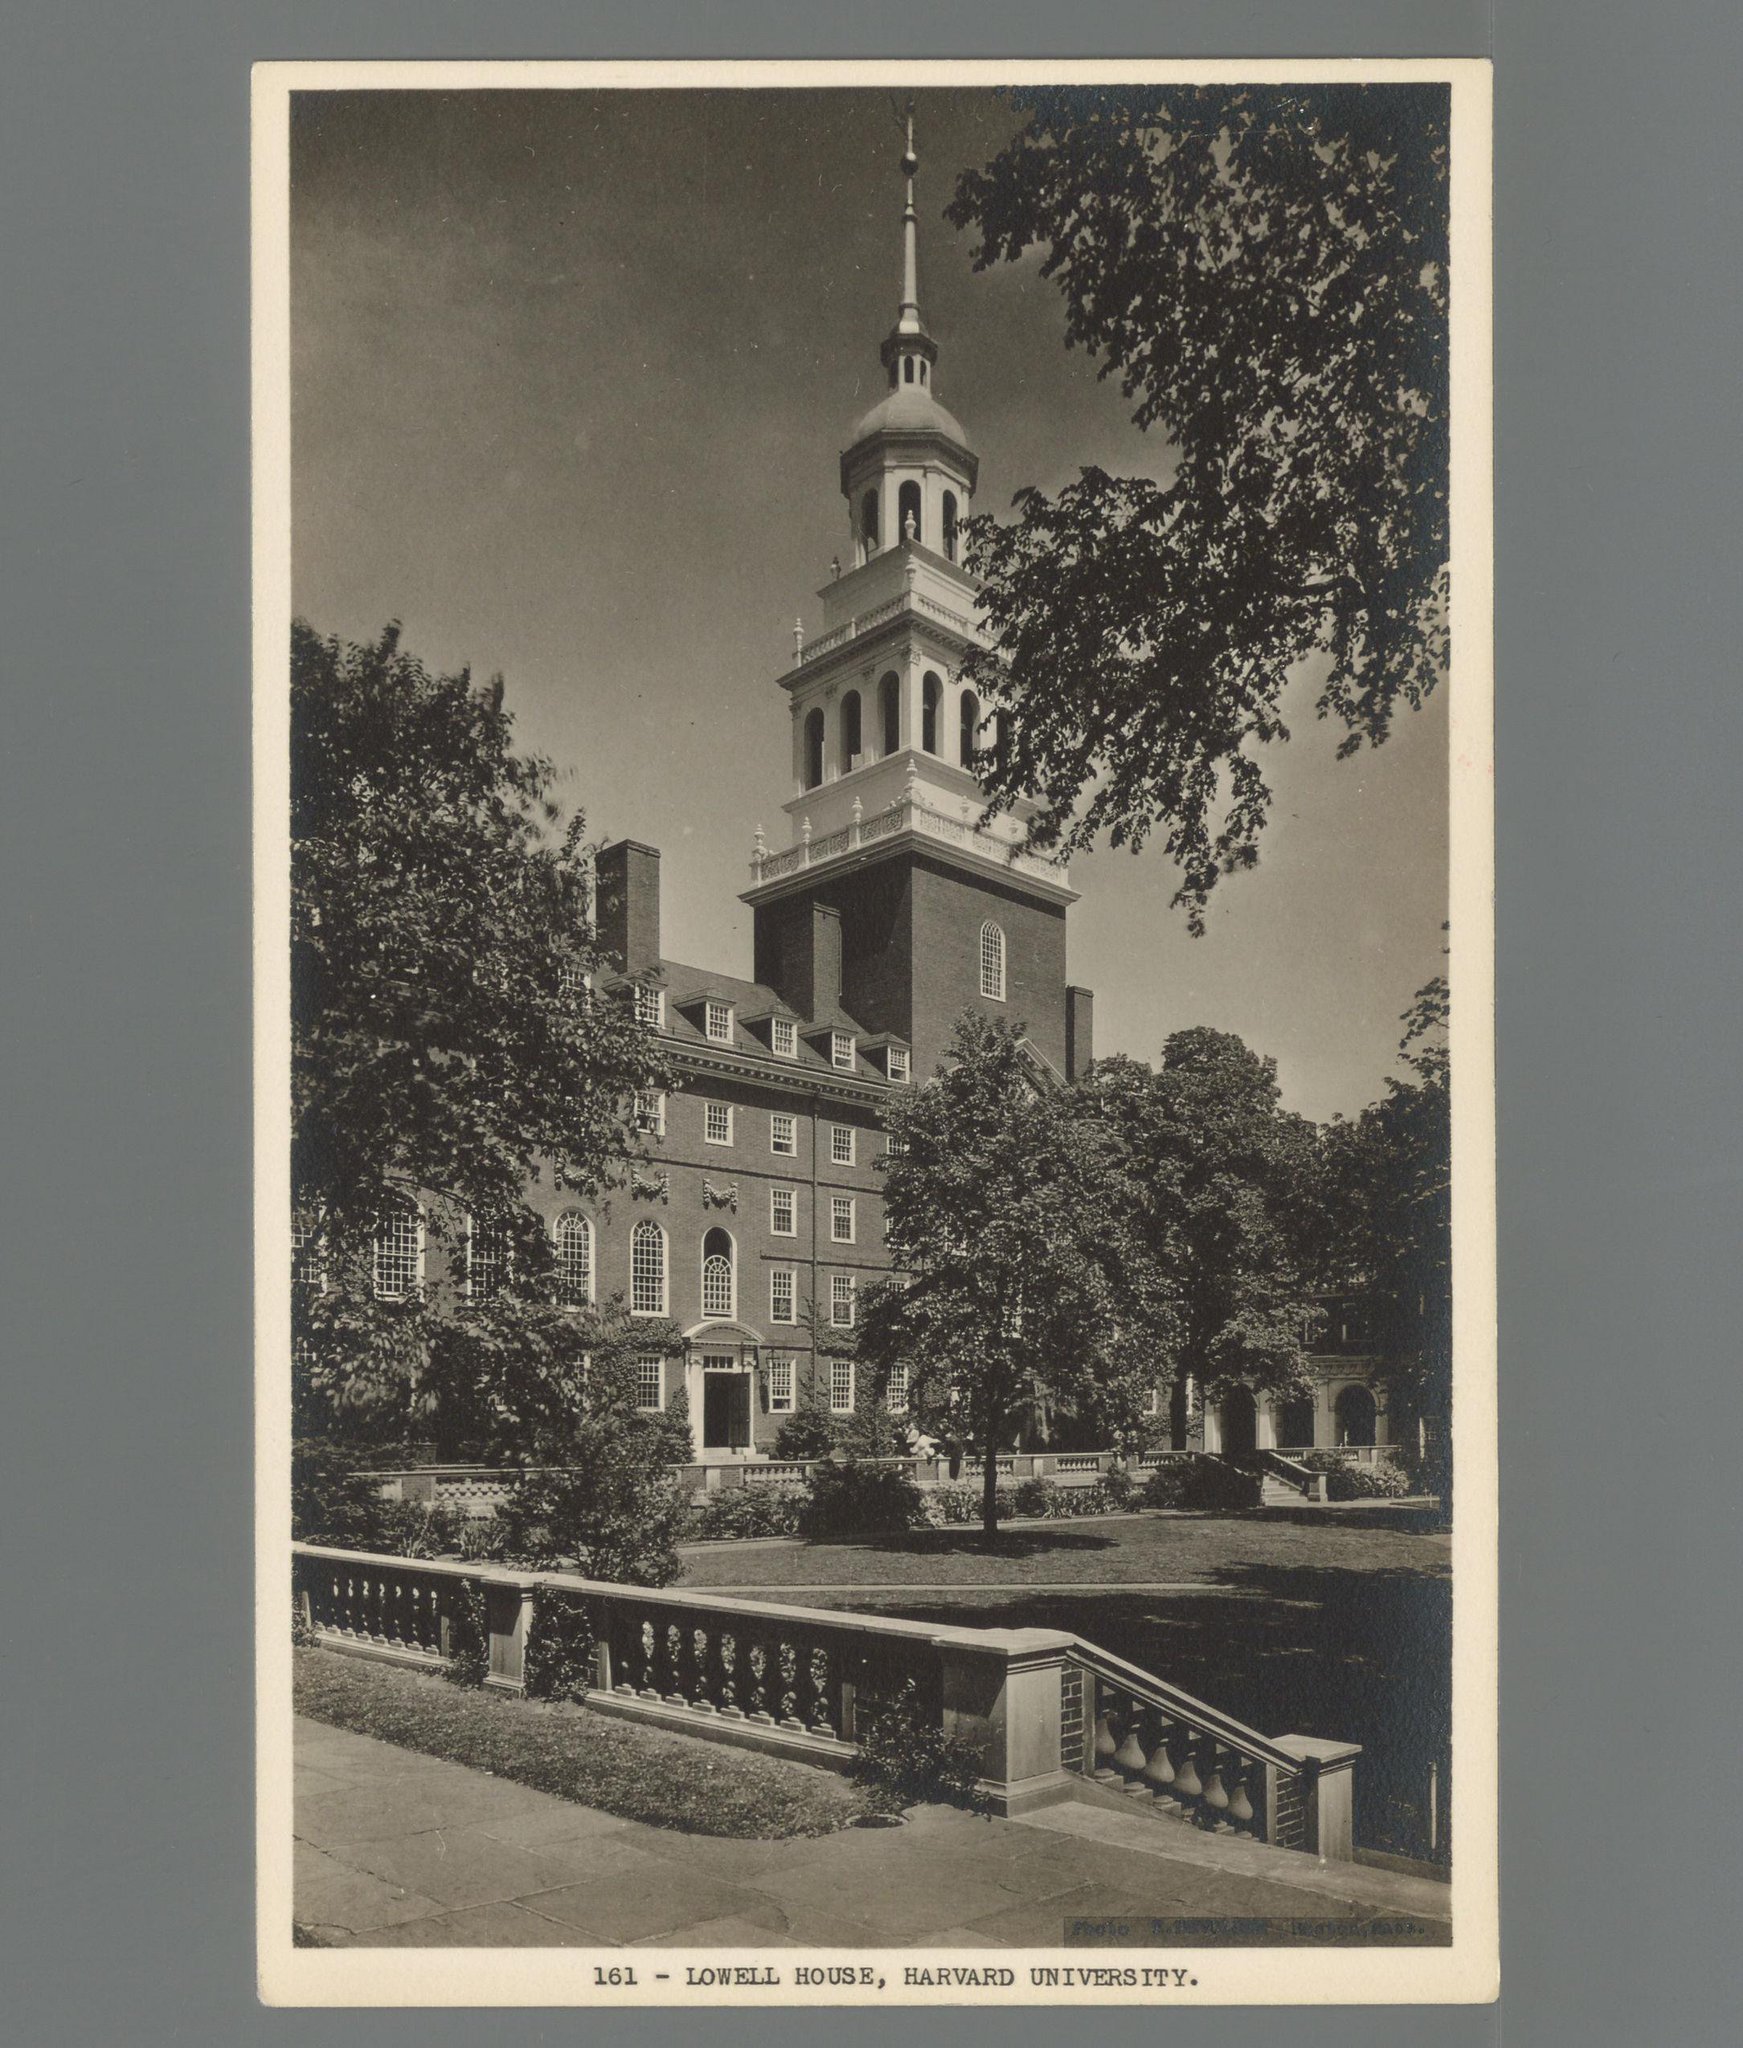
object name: photograph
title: Lowell House, Harvard University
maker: Anonymous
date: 1926-1945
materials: photographic support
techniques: photography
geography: cambridge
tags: university (+ building ~ education, tuition), exterior ~ representation of a building